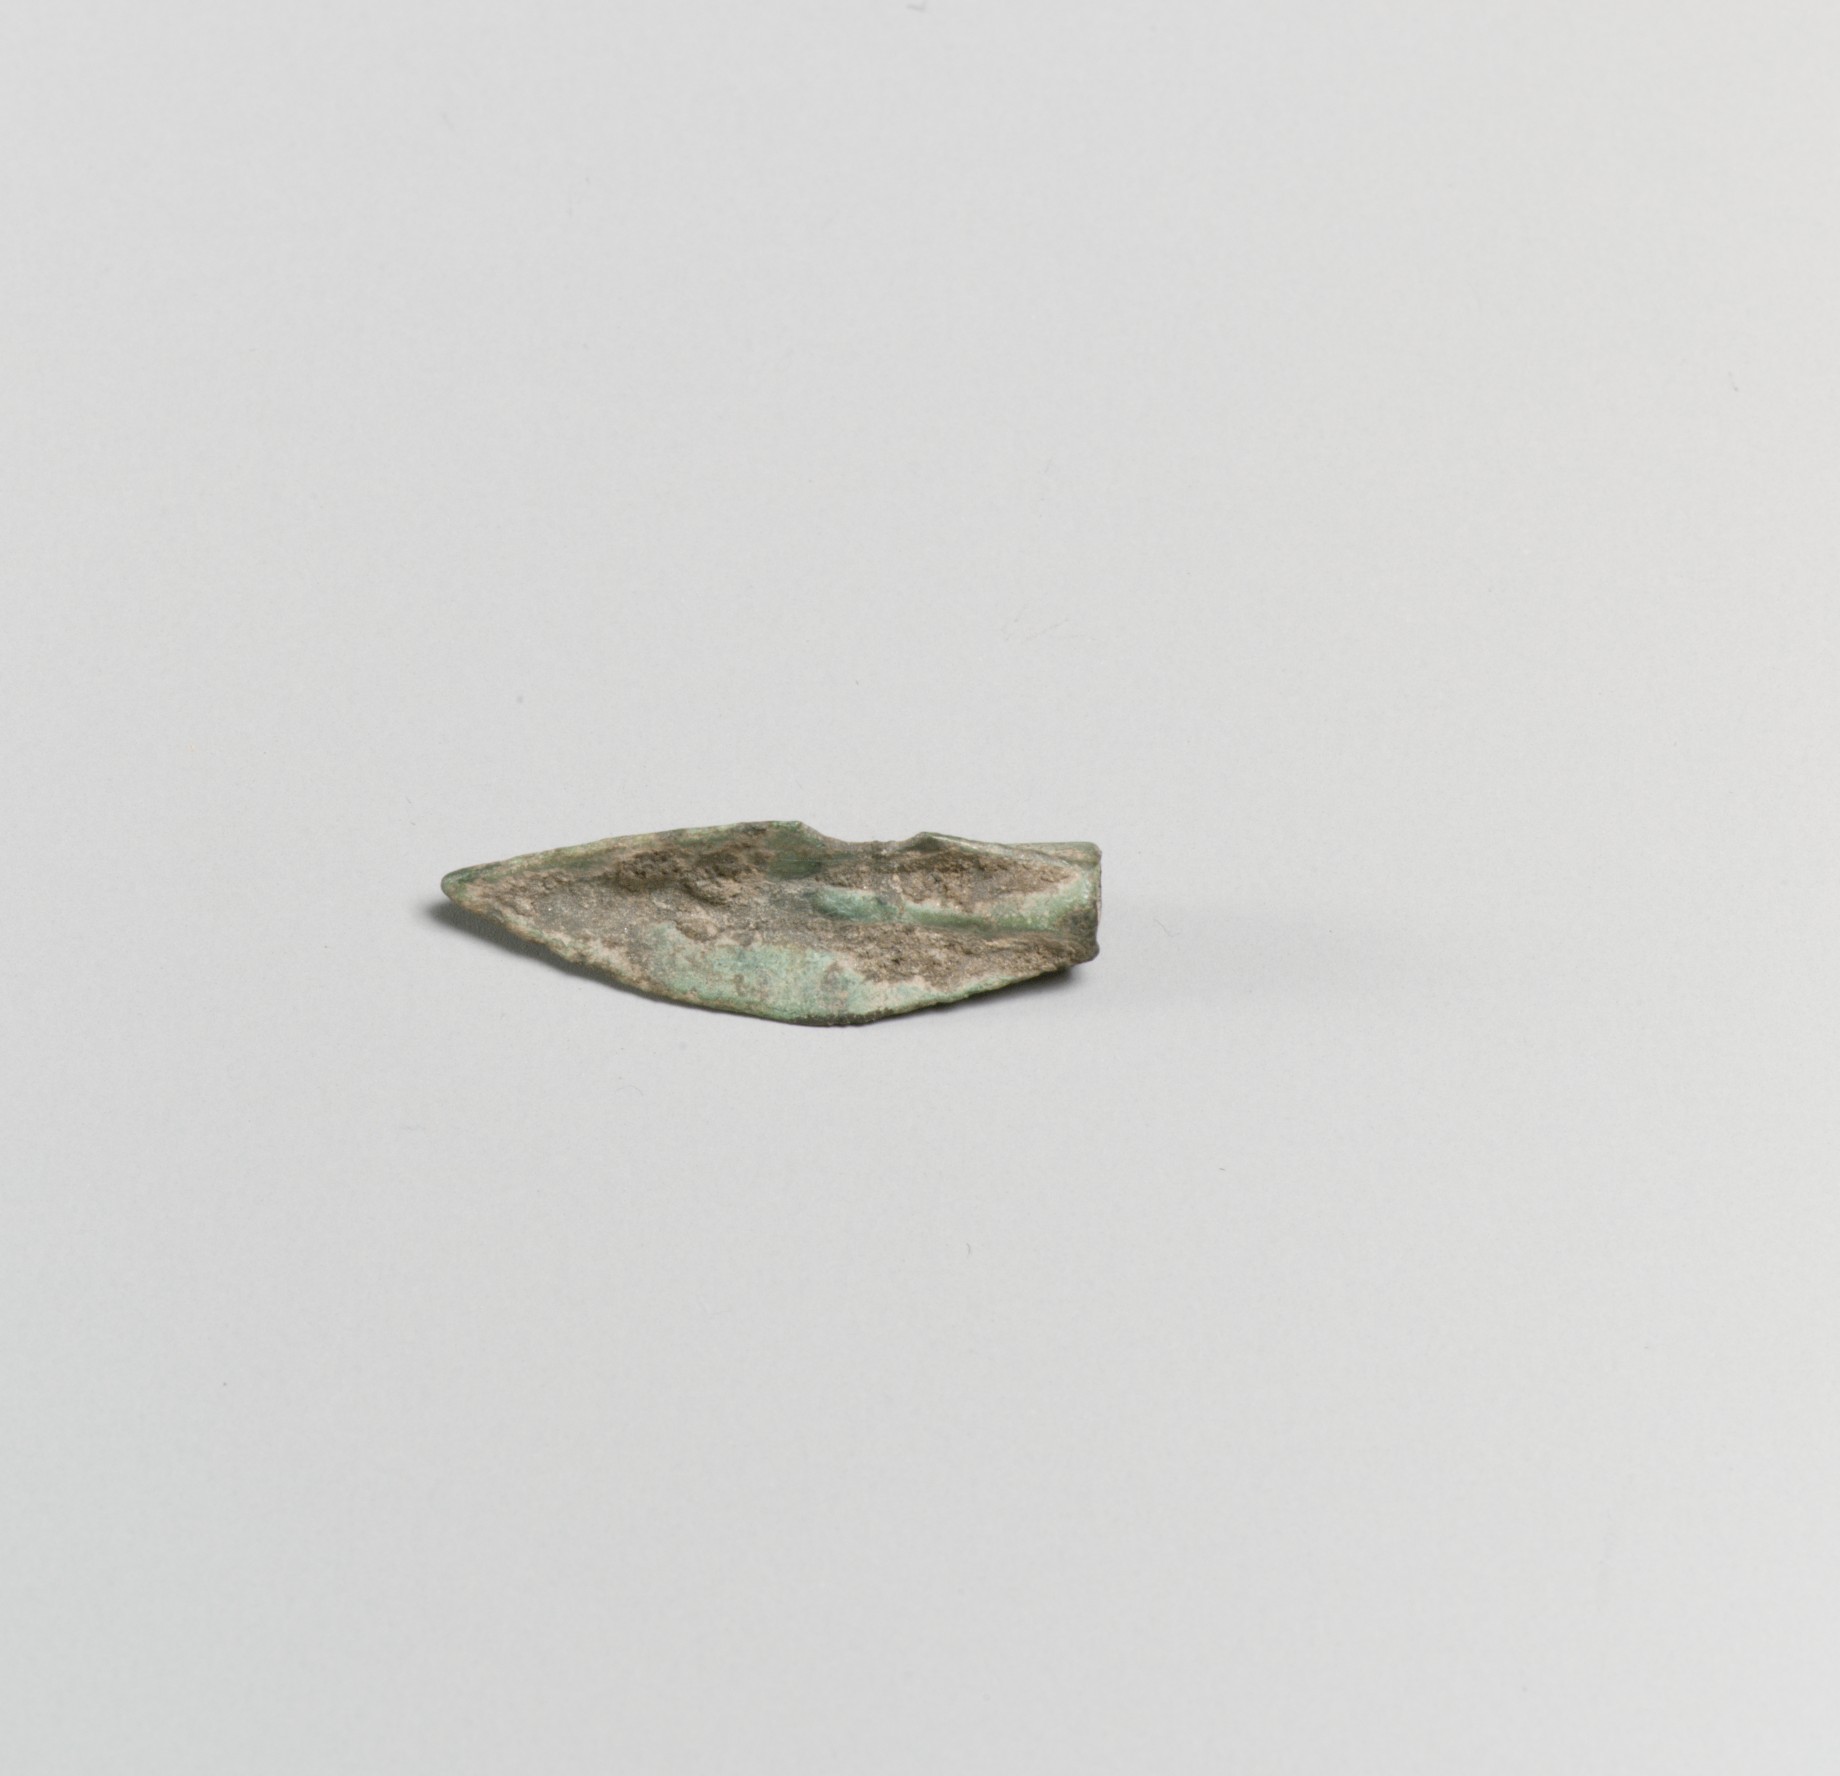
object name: arrowhead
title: Bronze arrowhead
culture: achaemenid or greek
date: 400-501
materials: bronze